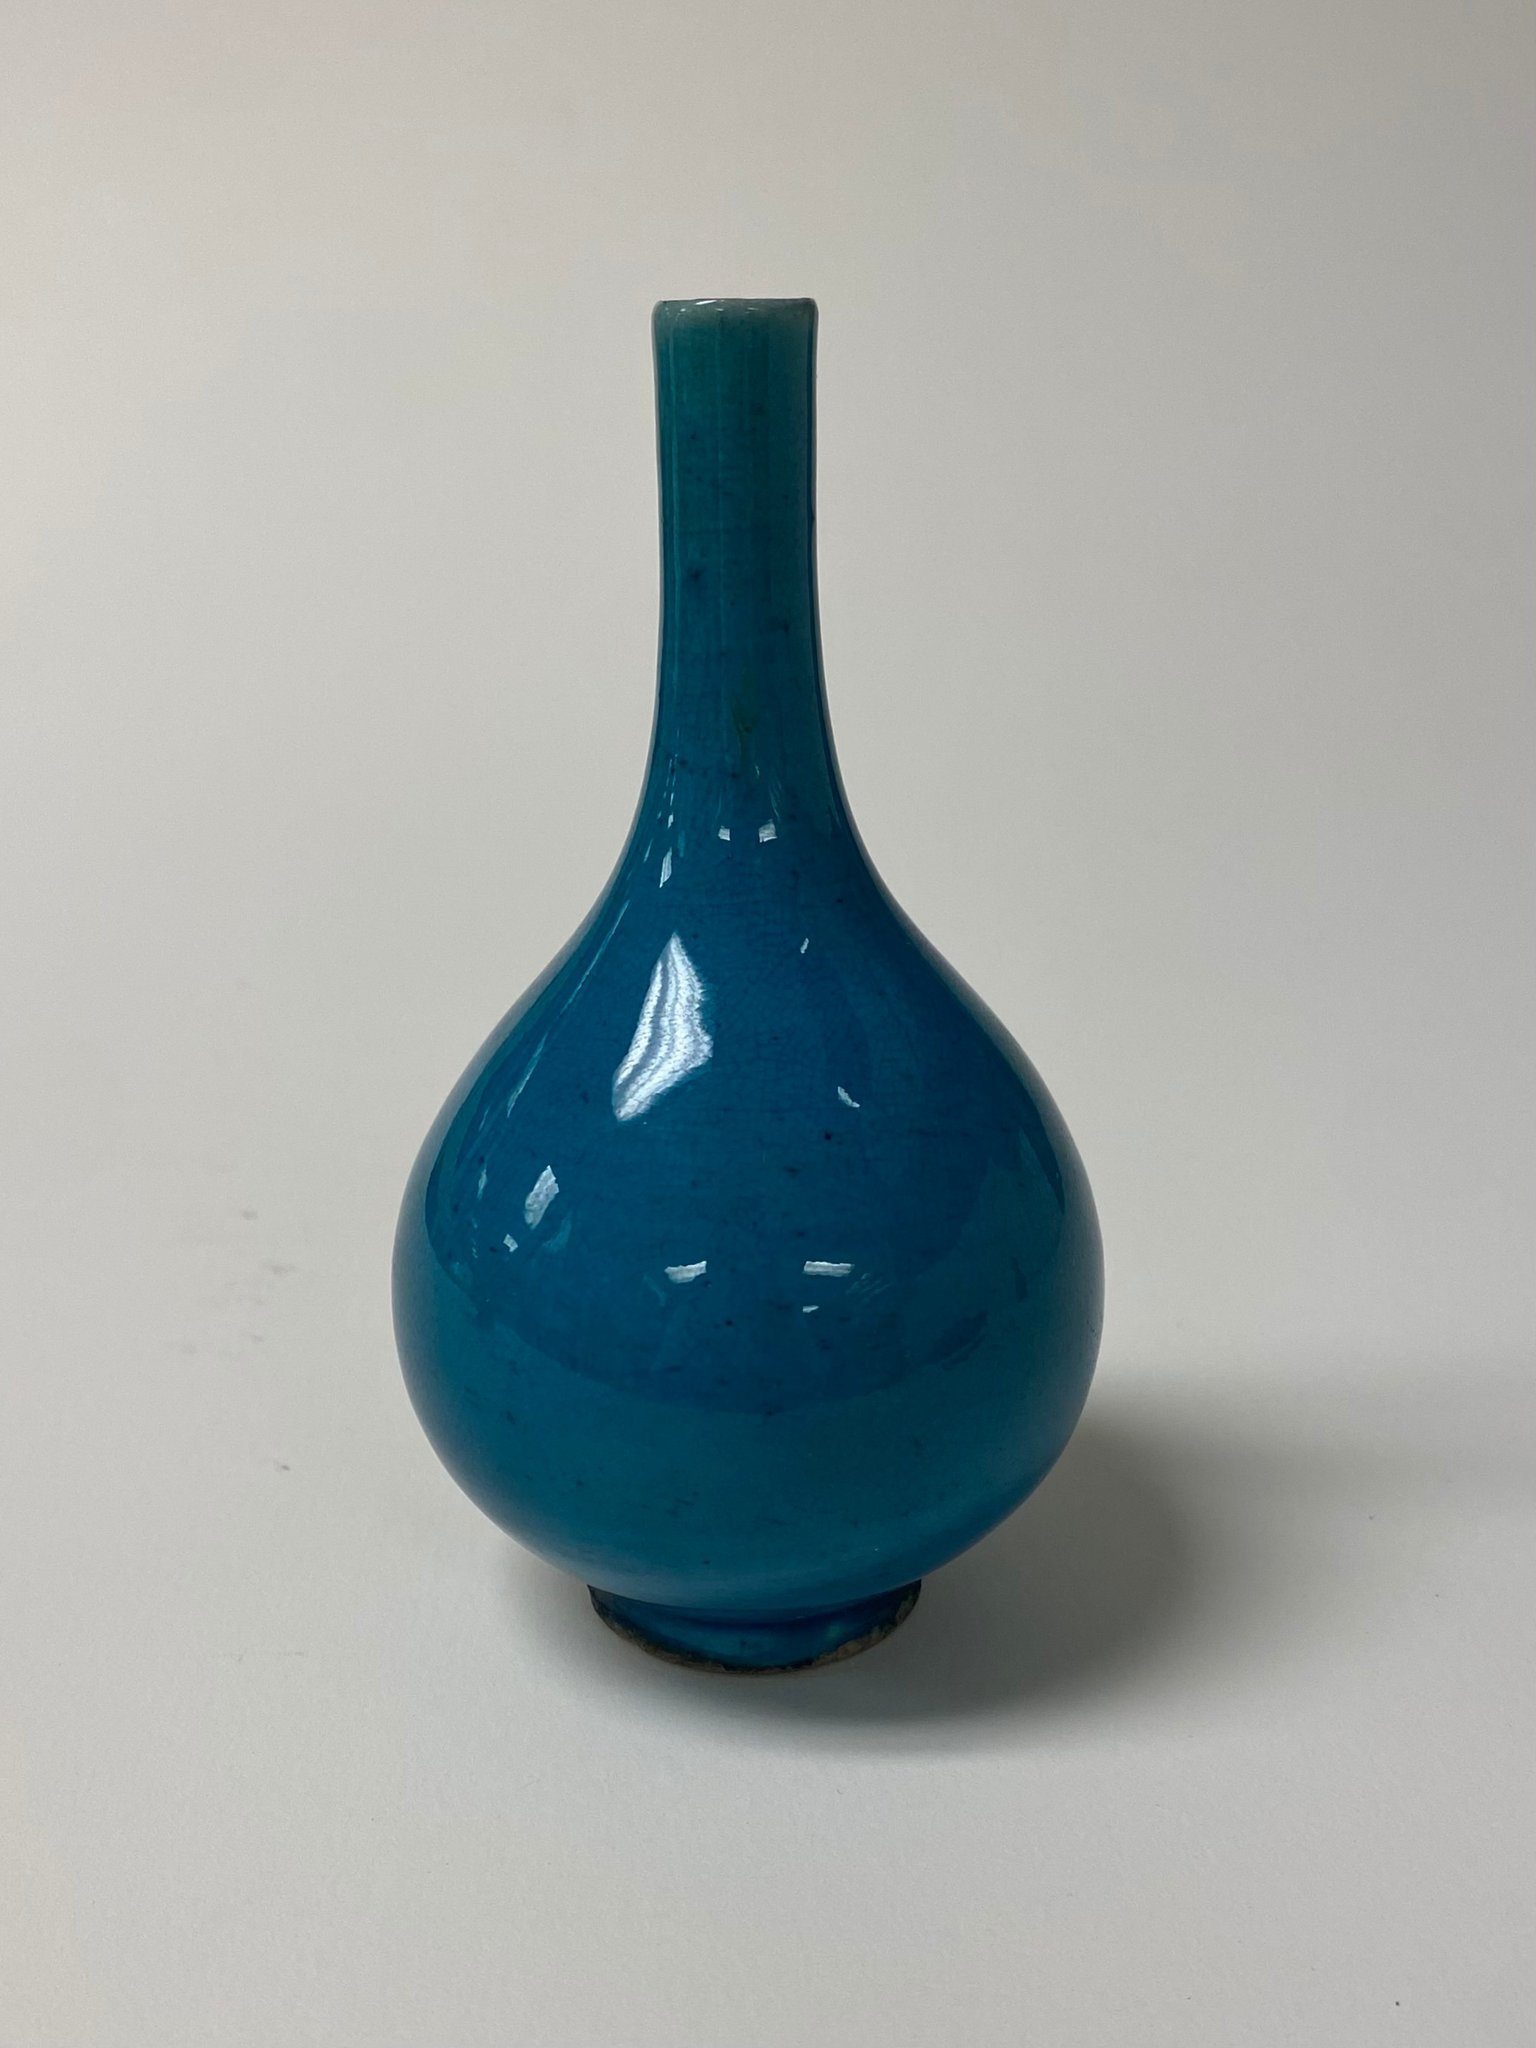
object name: bottle vase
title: Minature bottle vase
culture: chinese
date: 1701-1800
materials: glaze, porcelain